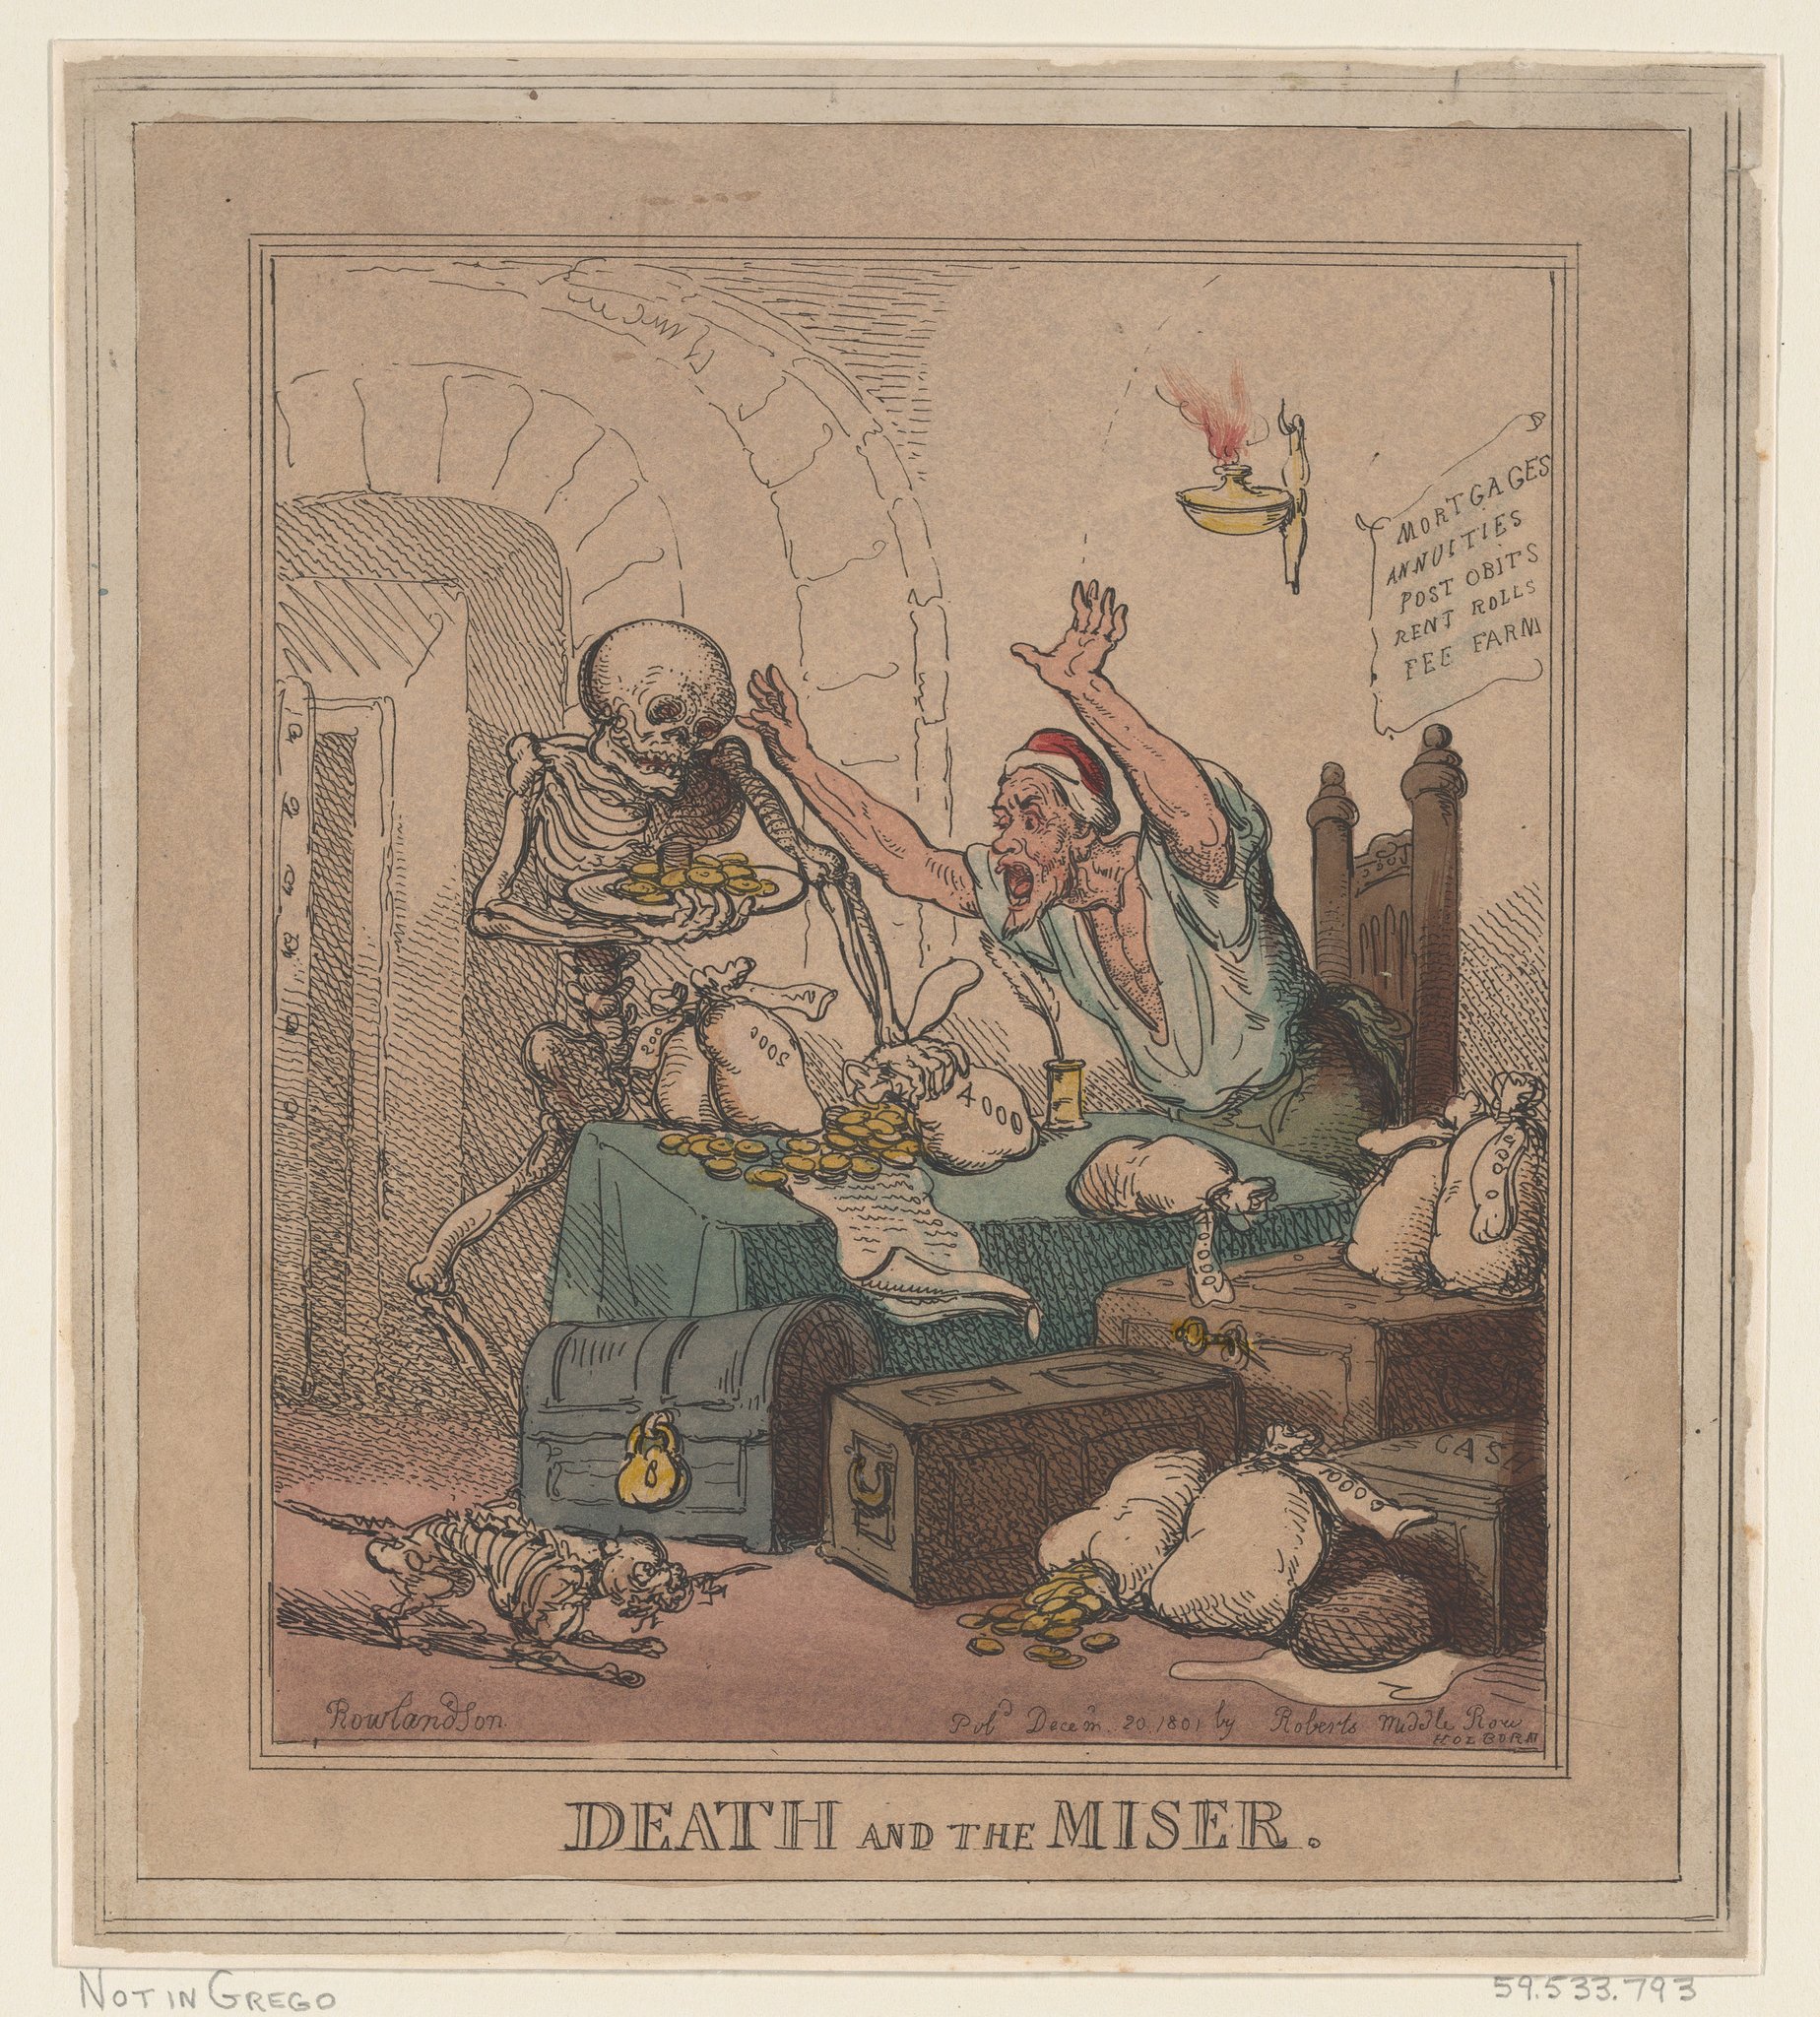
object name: print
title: Death and the Miser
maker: thomas rowlandson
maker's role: artist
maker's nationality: british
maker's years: 1757-1827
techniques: etching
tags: skeletons,men,chests